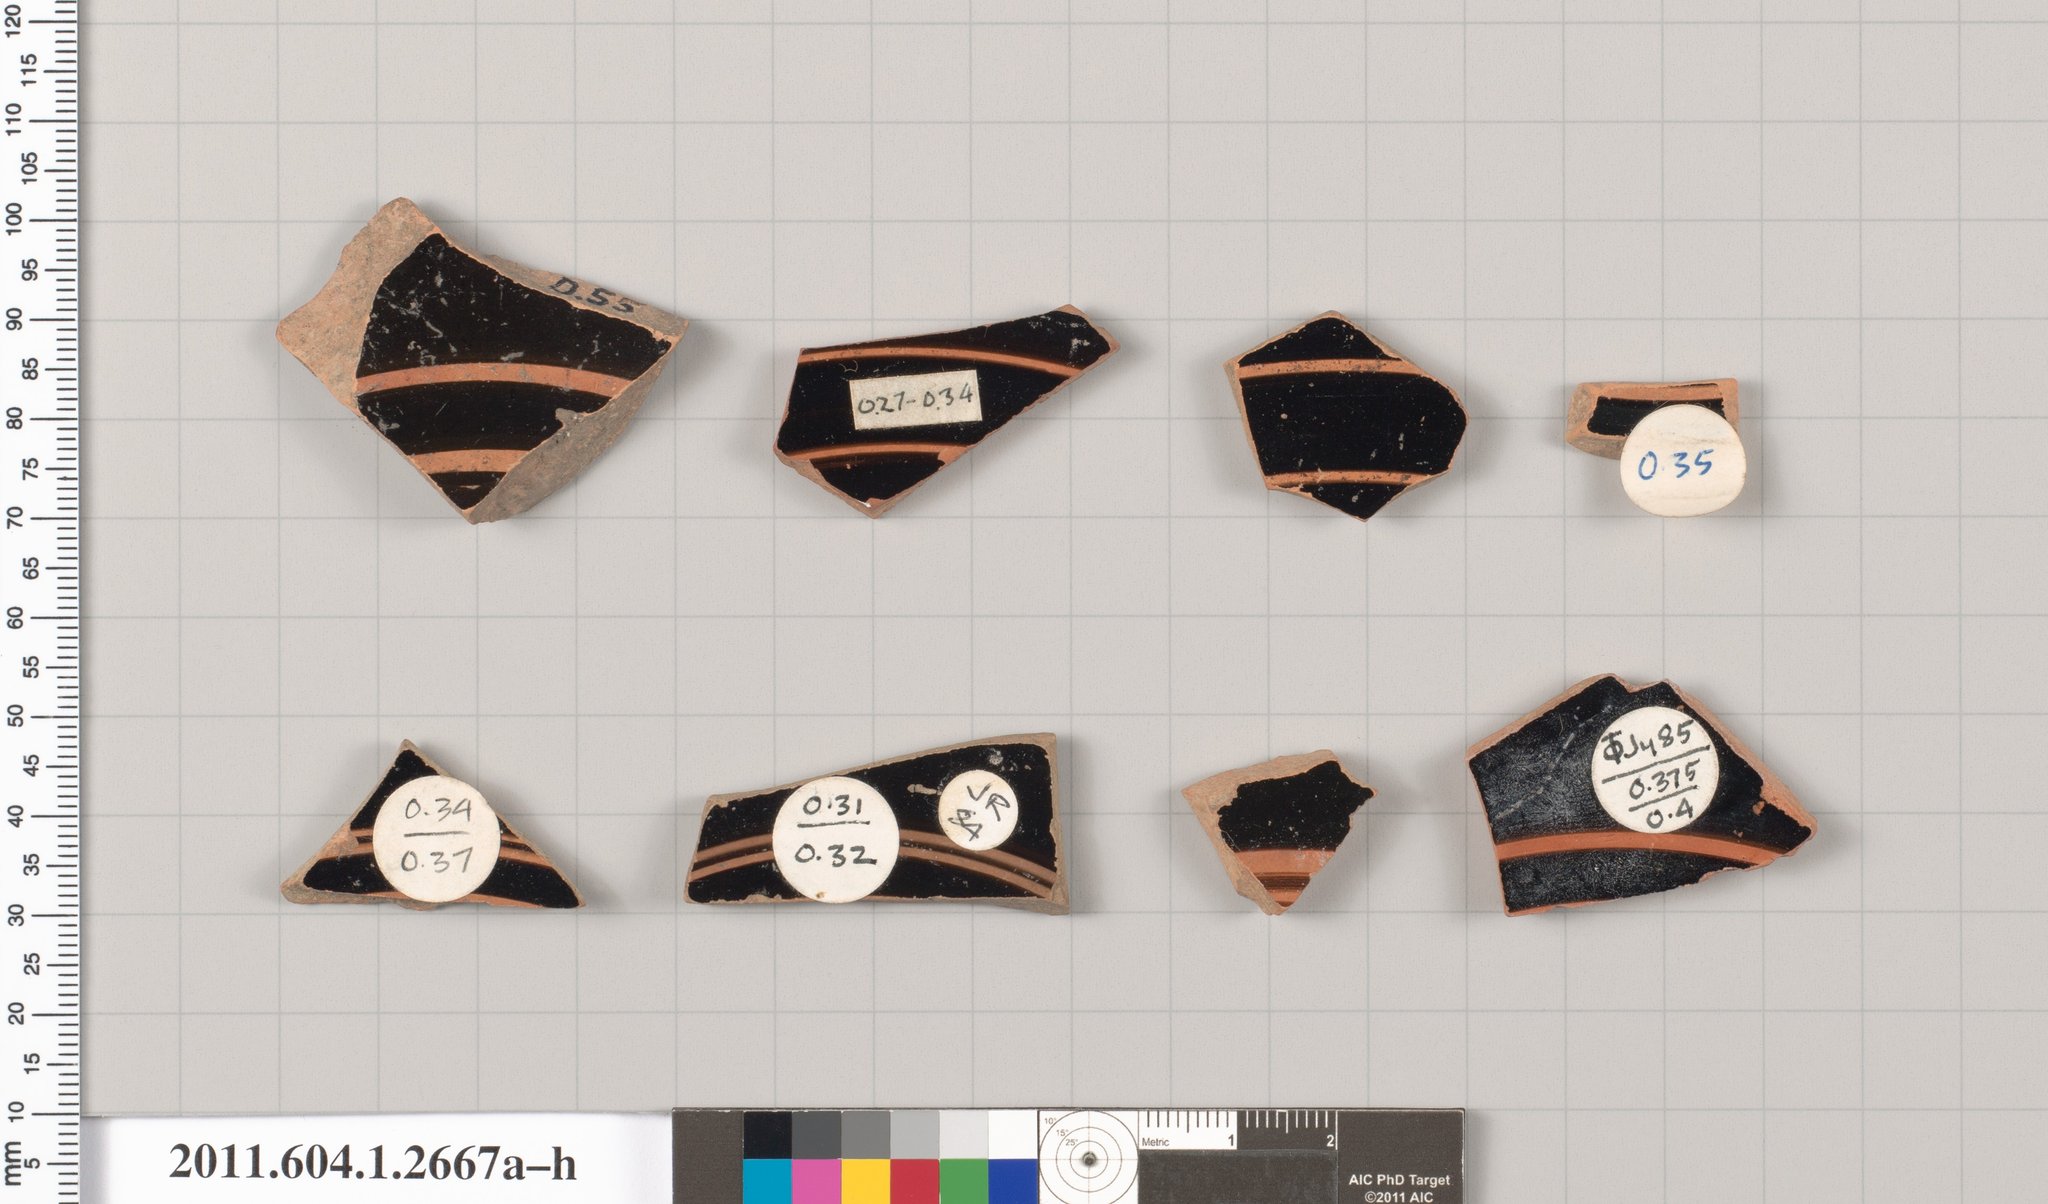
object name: kylix fragment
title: Terracotta fragments of kylikes (drinking cups)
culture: greek, attic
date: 500-476 BCE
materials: terracotta